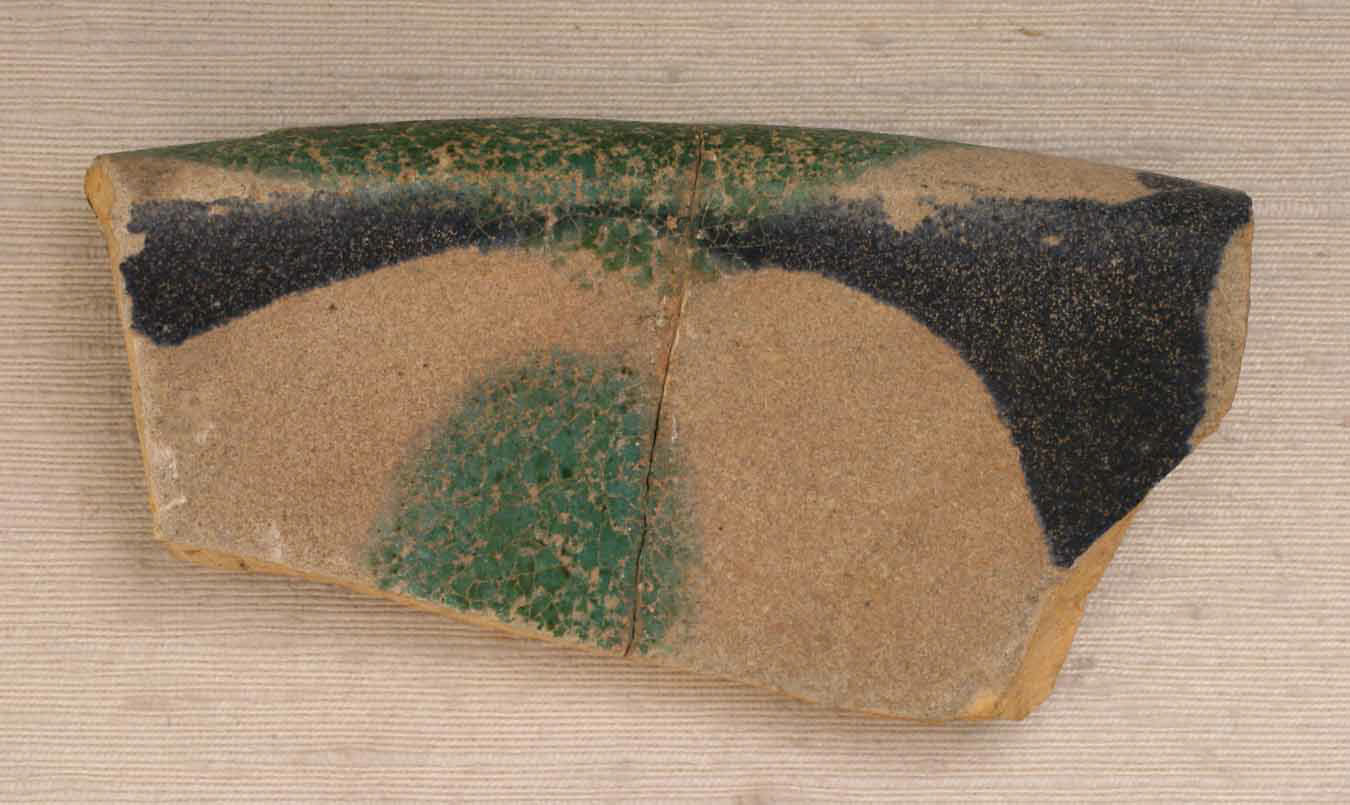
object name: fragment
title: Fragments of Ceramics Painted on Opacified Glaze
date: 801-900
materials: earthenware, glaze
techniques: painting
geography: iraq